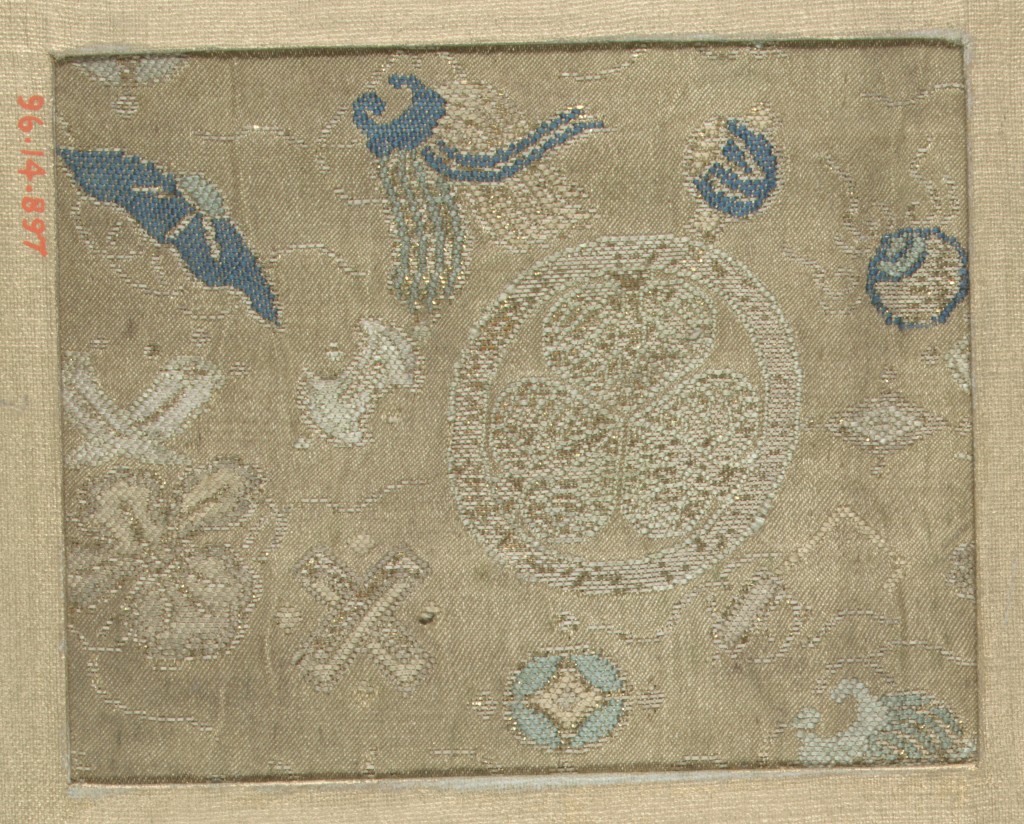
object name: piece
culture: japanese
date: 1701-1900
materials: silk